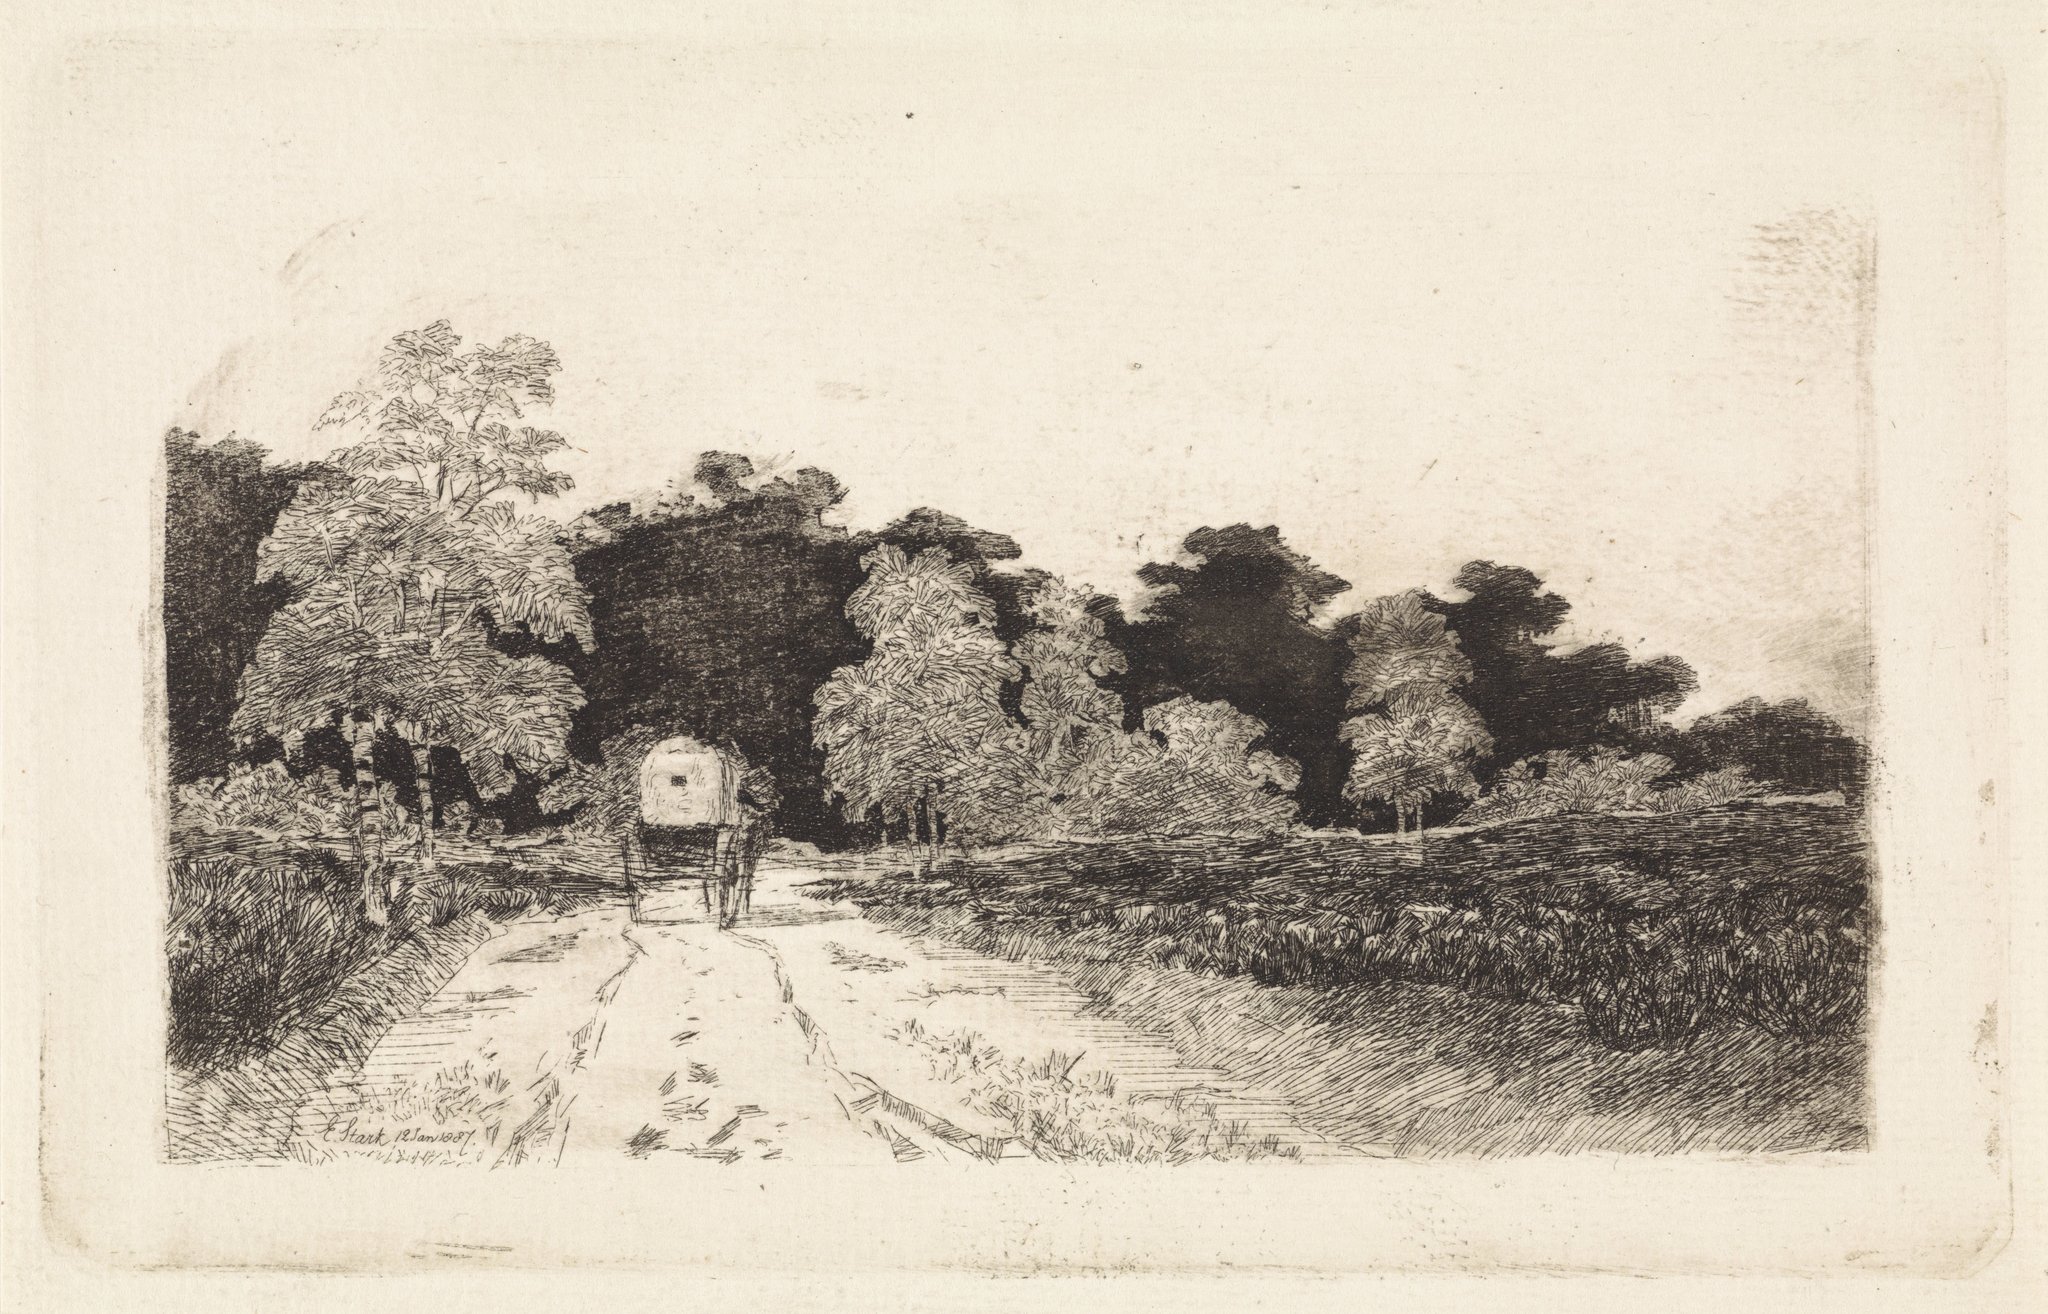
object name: print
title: Huifkar op een weg te Driebergen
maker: elias stark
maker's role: draughtsman, print maker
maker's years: 1849-1933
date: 1887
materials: paper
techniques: etching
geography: nieuwer-amstel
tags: covered wagon, hooded wagon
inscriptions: collector's mark: Lugt 2228